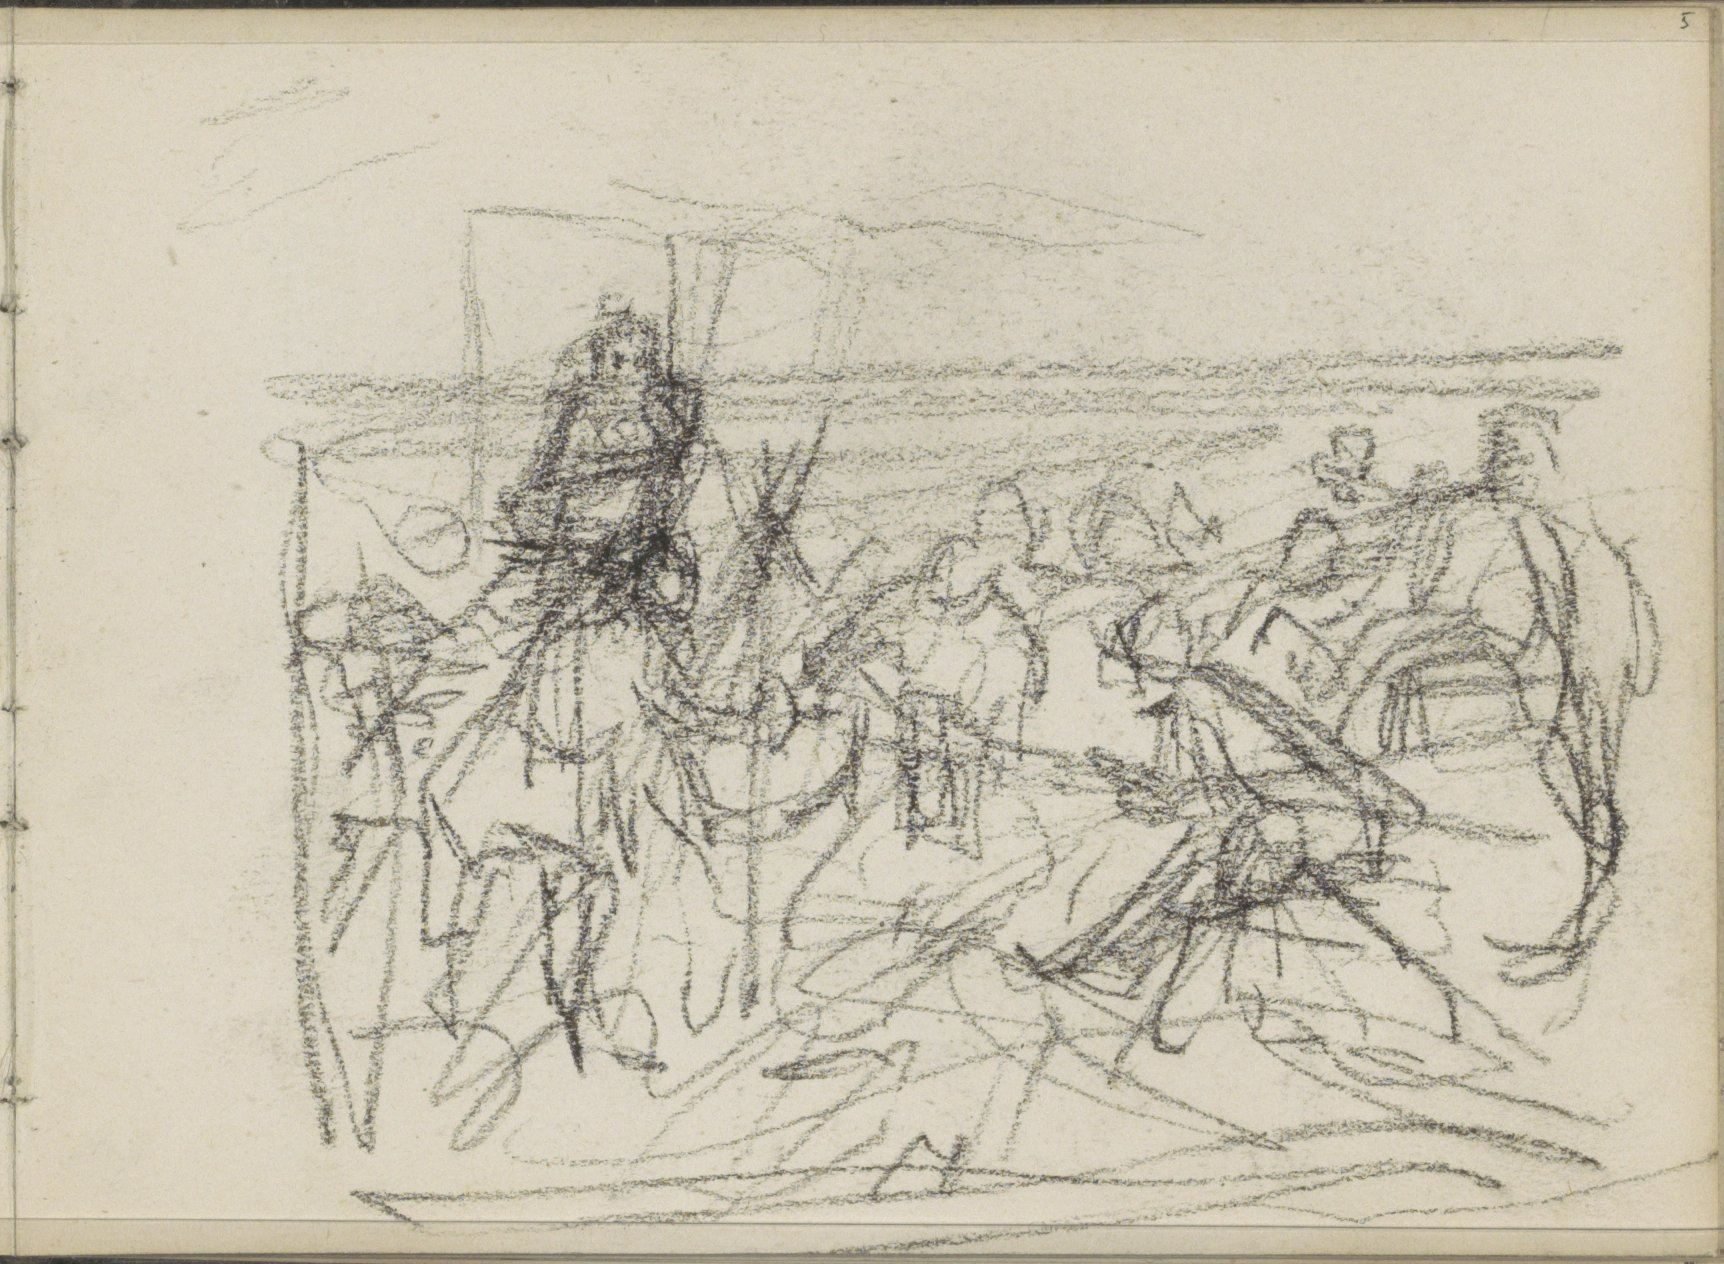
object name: sketchbook leaf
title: Groep figuren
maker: marius bauer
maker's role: draughtsman, print maker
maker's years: 1867-1932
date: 1877-1932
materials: chalk, paper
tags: anatomy (non-medical)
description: Pagina 5 uit een schetsboek met 32 bladen.